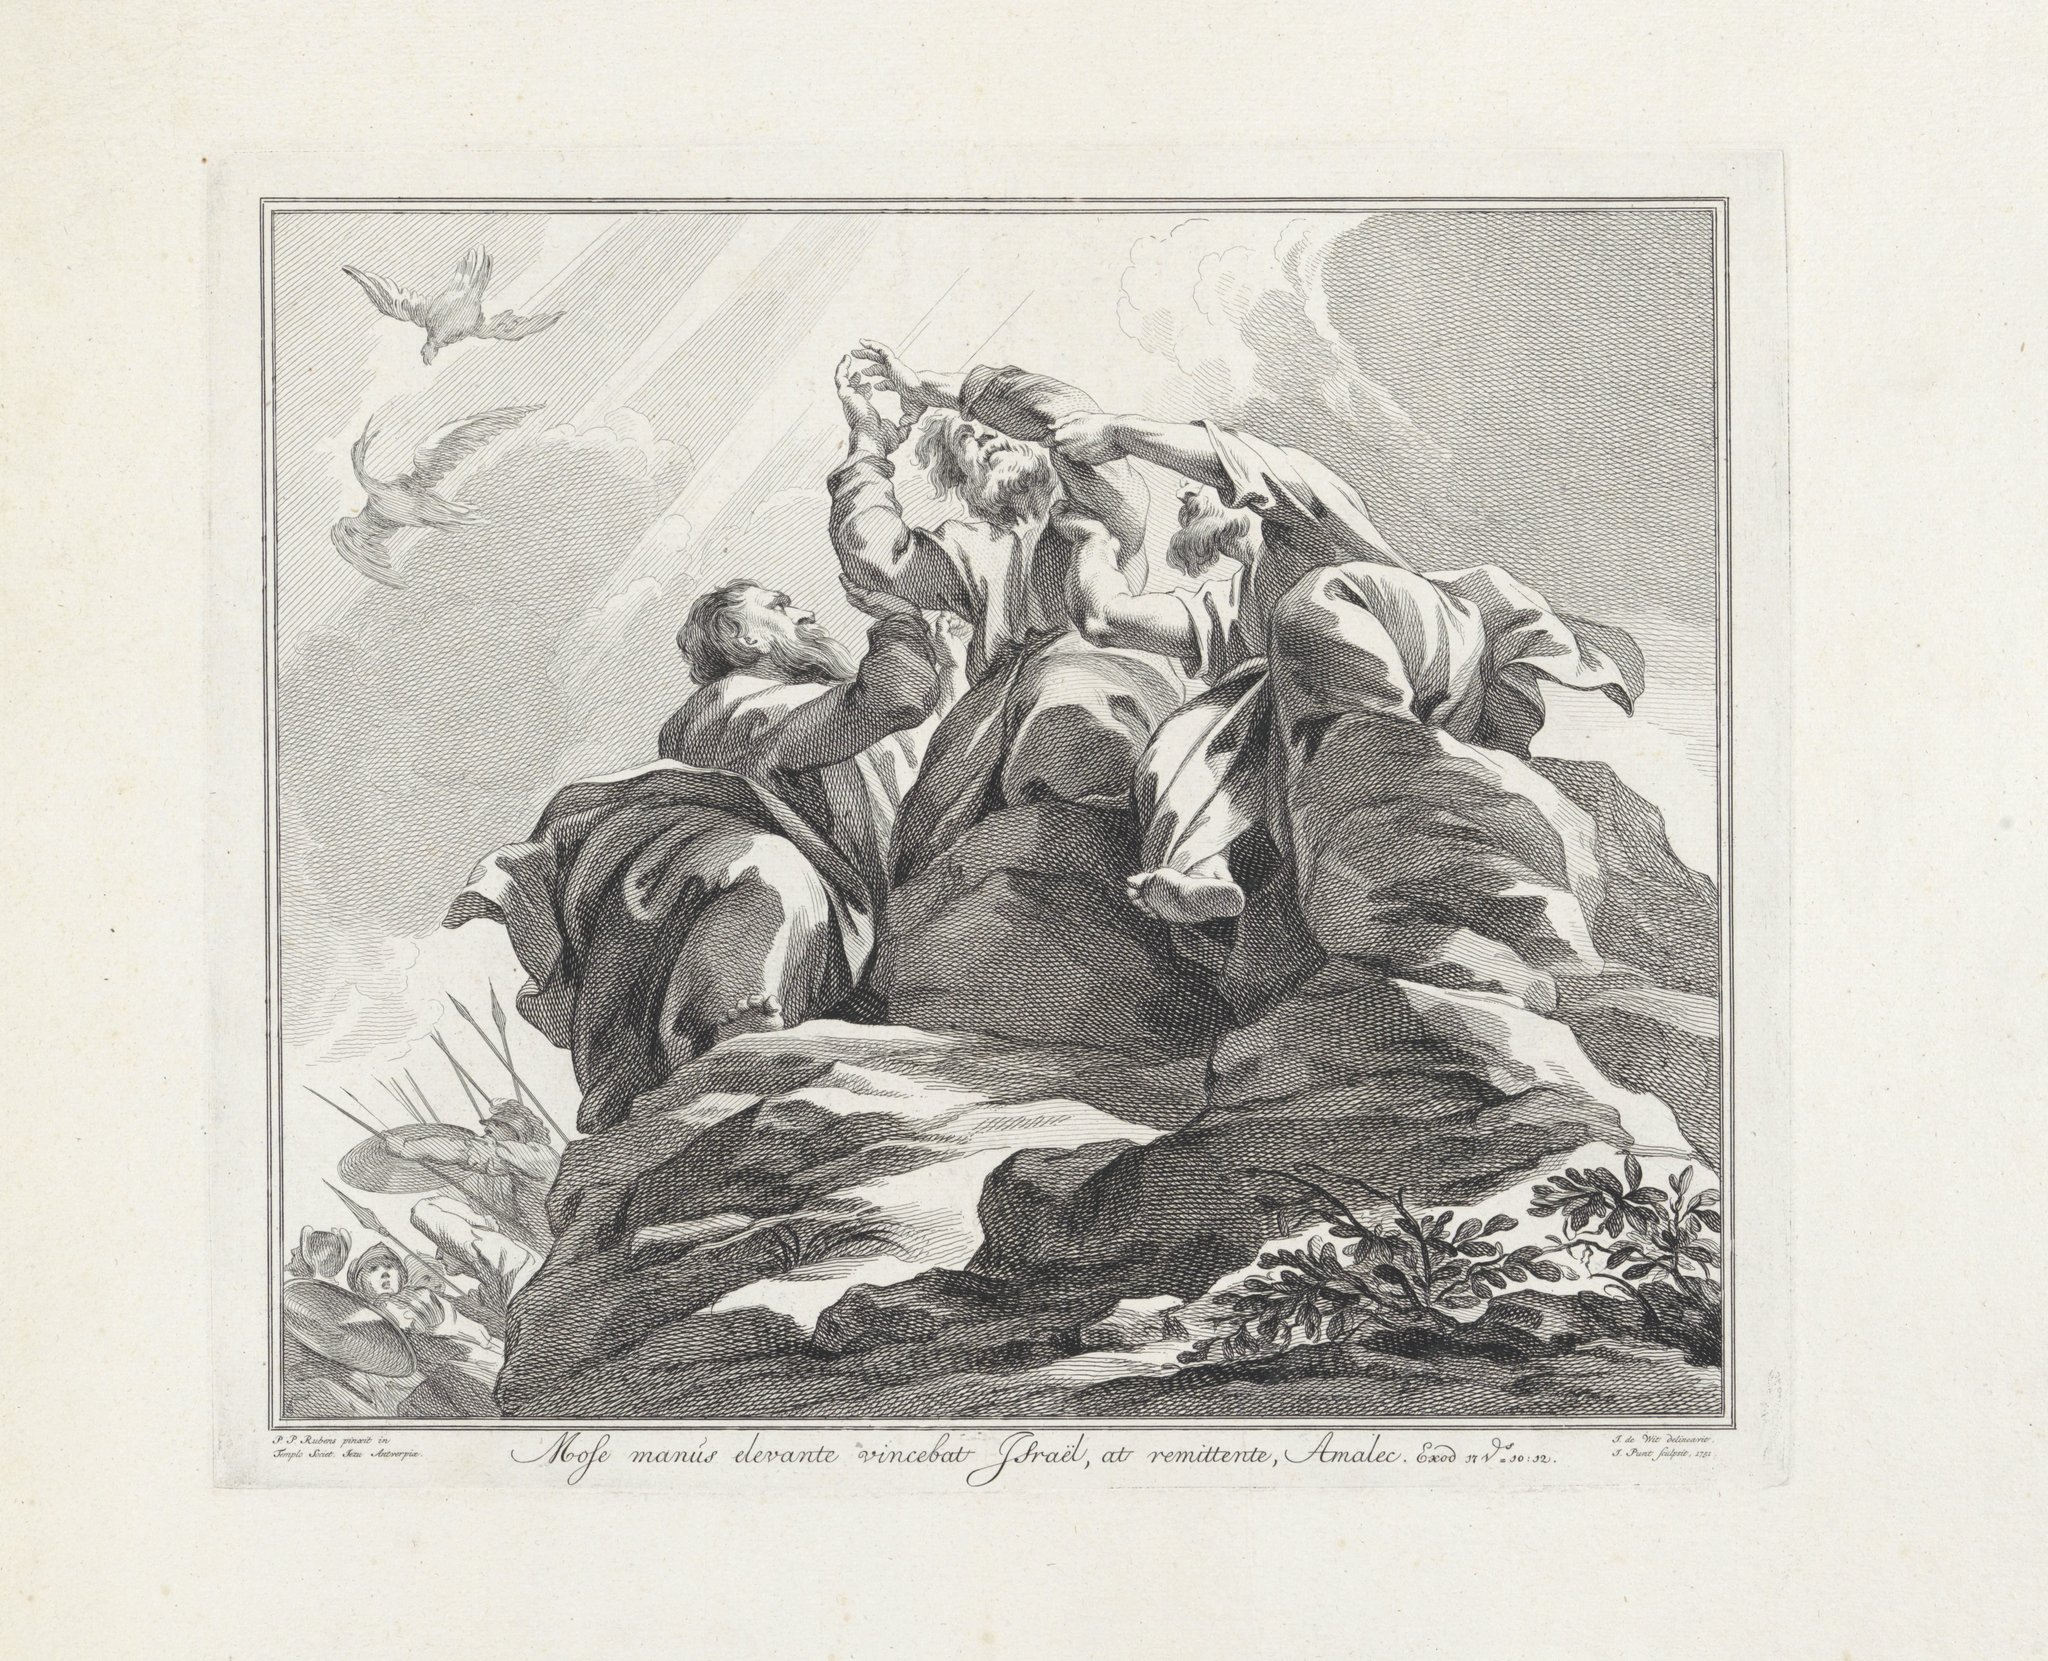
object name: print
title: Les plat-fonds ou les tableaux des galeries / De plafonds of gallerystukken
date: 1751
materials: paper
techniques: engraving, etching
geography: amsterdam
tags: moses goes to the top of a hill with aaron and hur and raises his arms to make the israelites victorious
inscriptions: date: ‘1751’, collector's mark: Lugt 2228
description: Mozes' armen worden omhooggehouden door Aäron en Hur. Onder de rechthoekige voorstelling een vers in het Latijn uit Ex. 17:10-12.